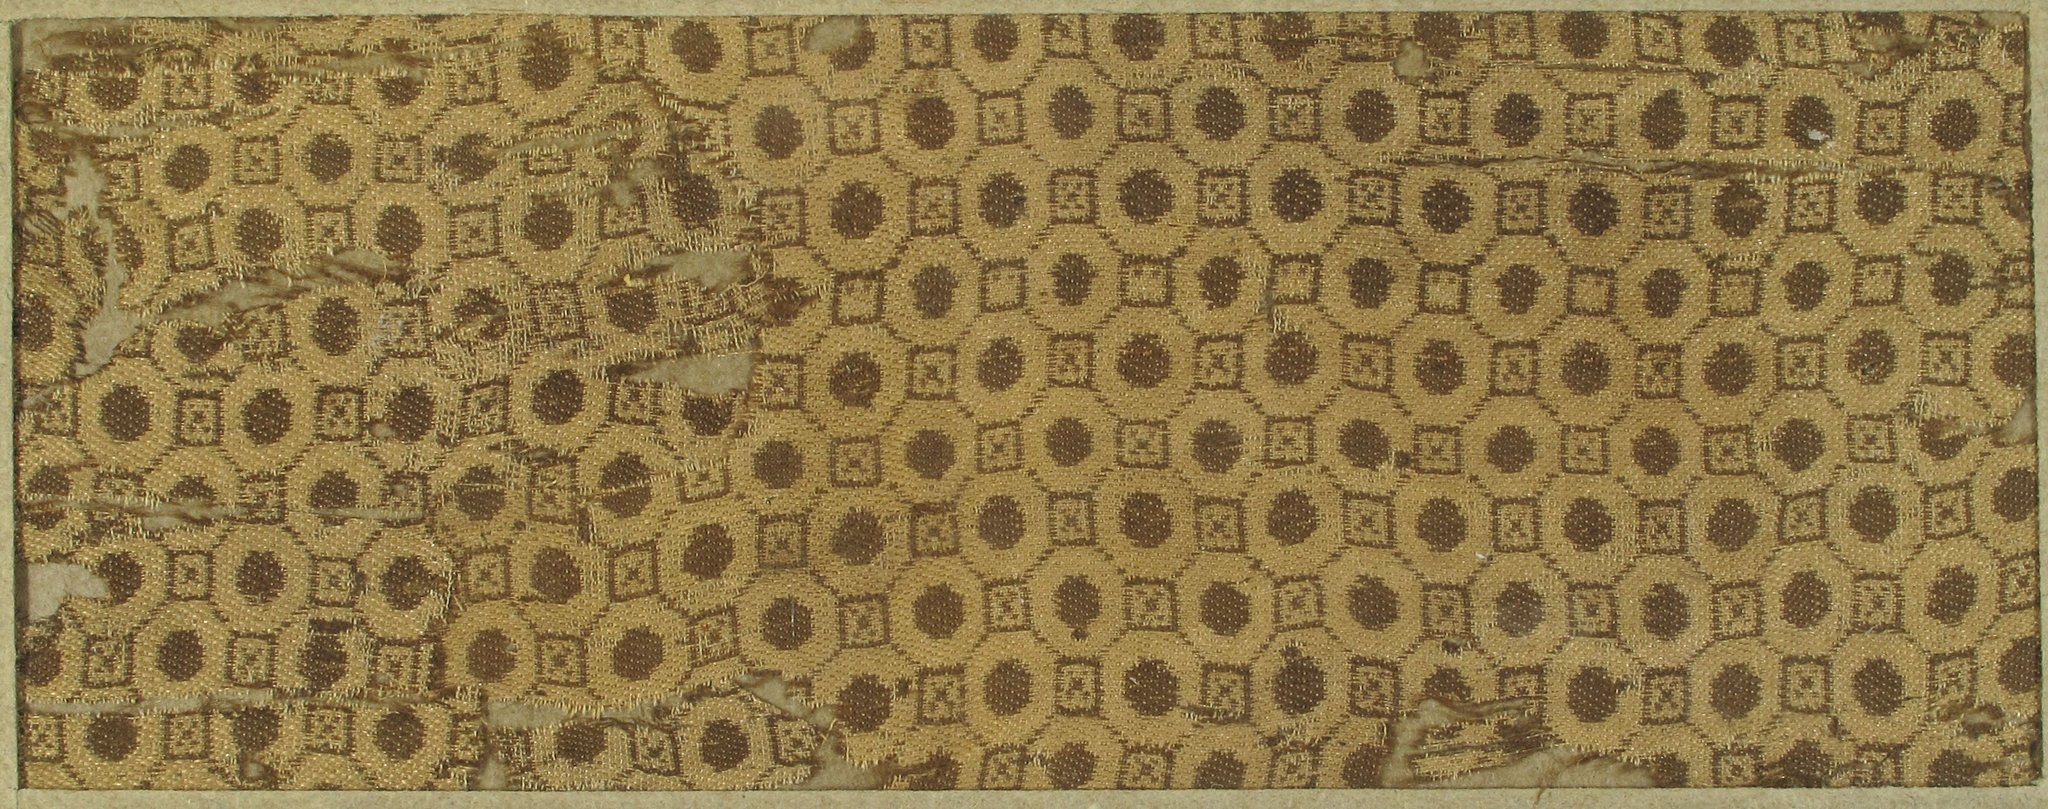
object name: textile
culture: byzantine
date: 901-1100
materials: silk